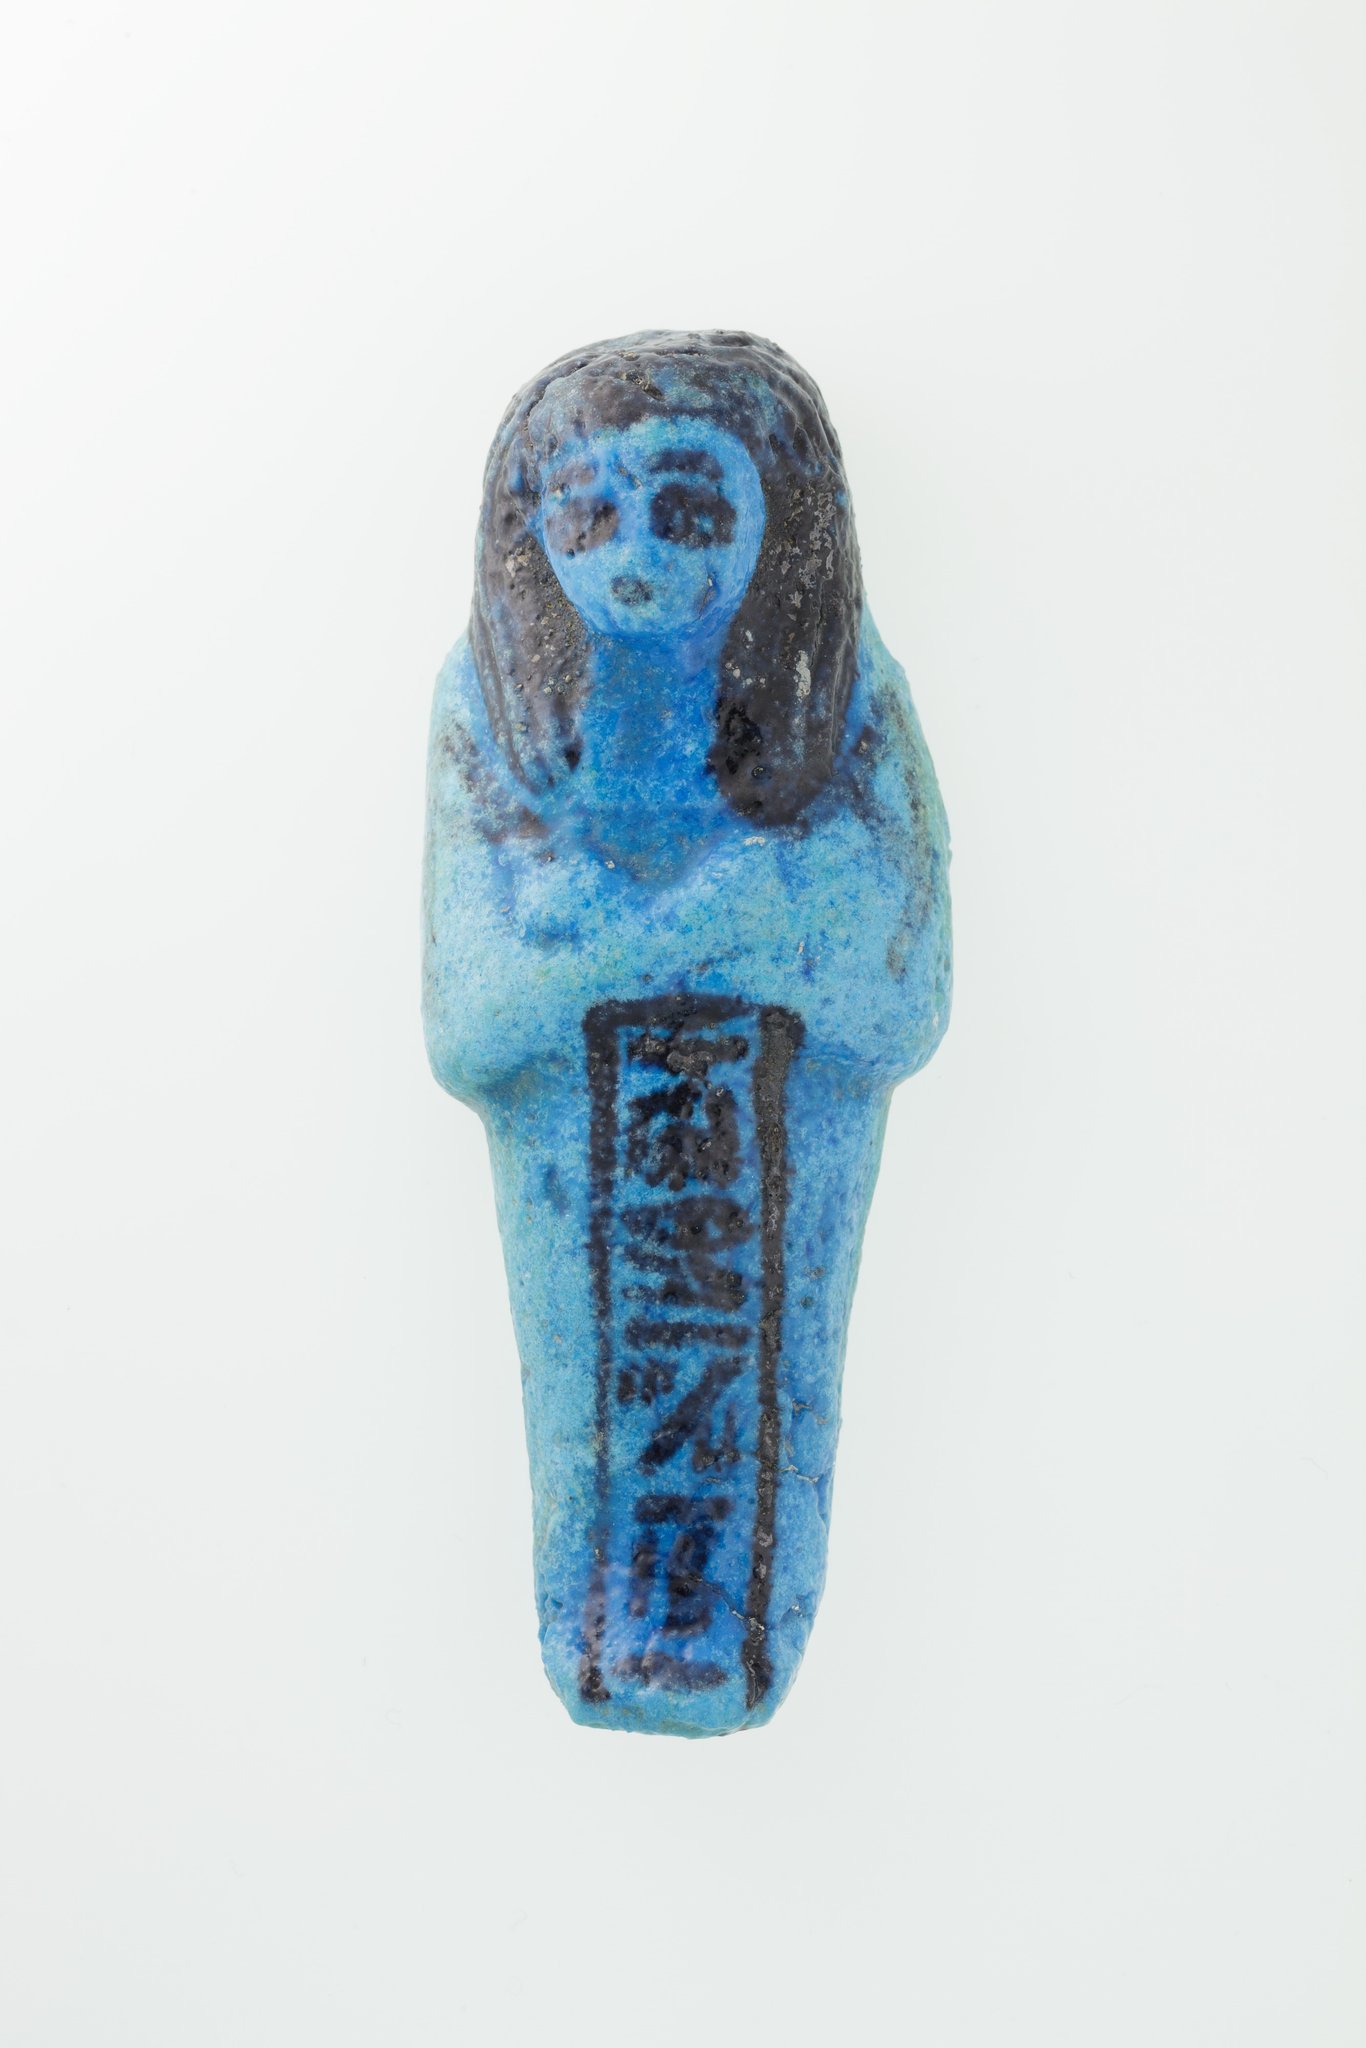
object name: shabti, worker, nauny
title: Worker Shabti of Nauny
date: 1050 BCE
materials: faience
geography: egypt